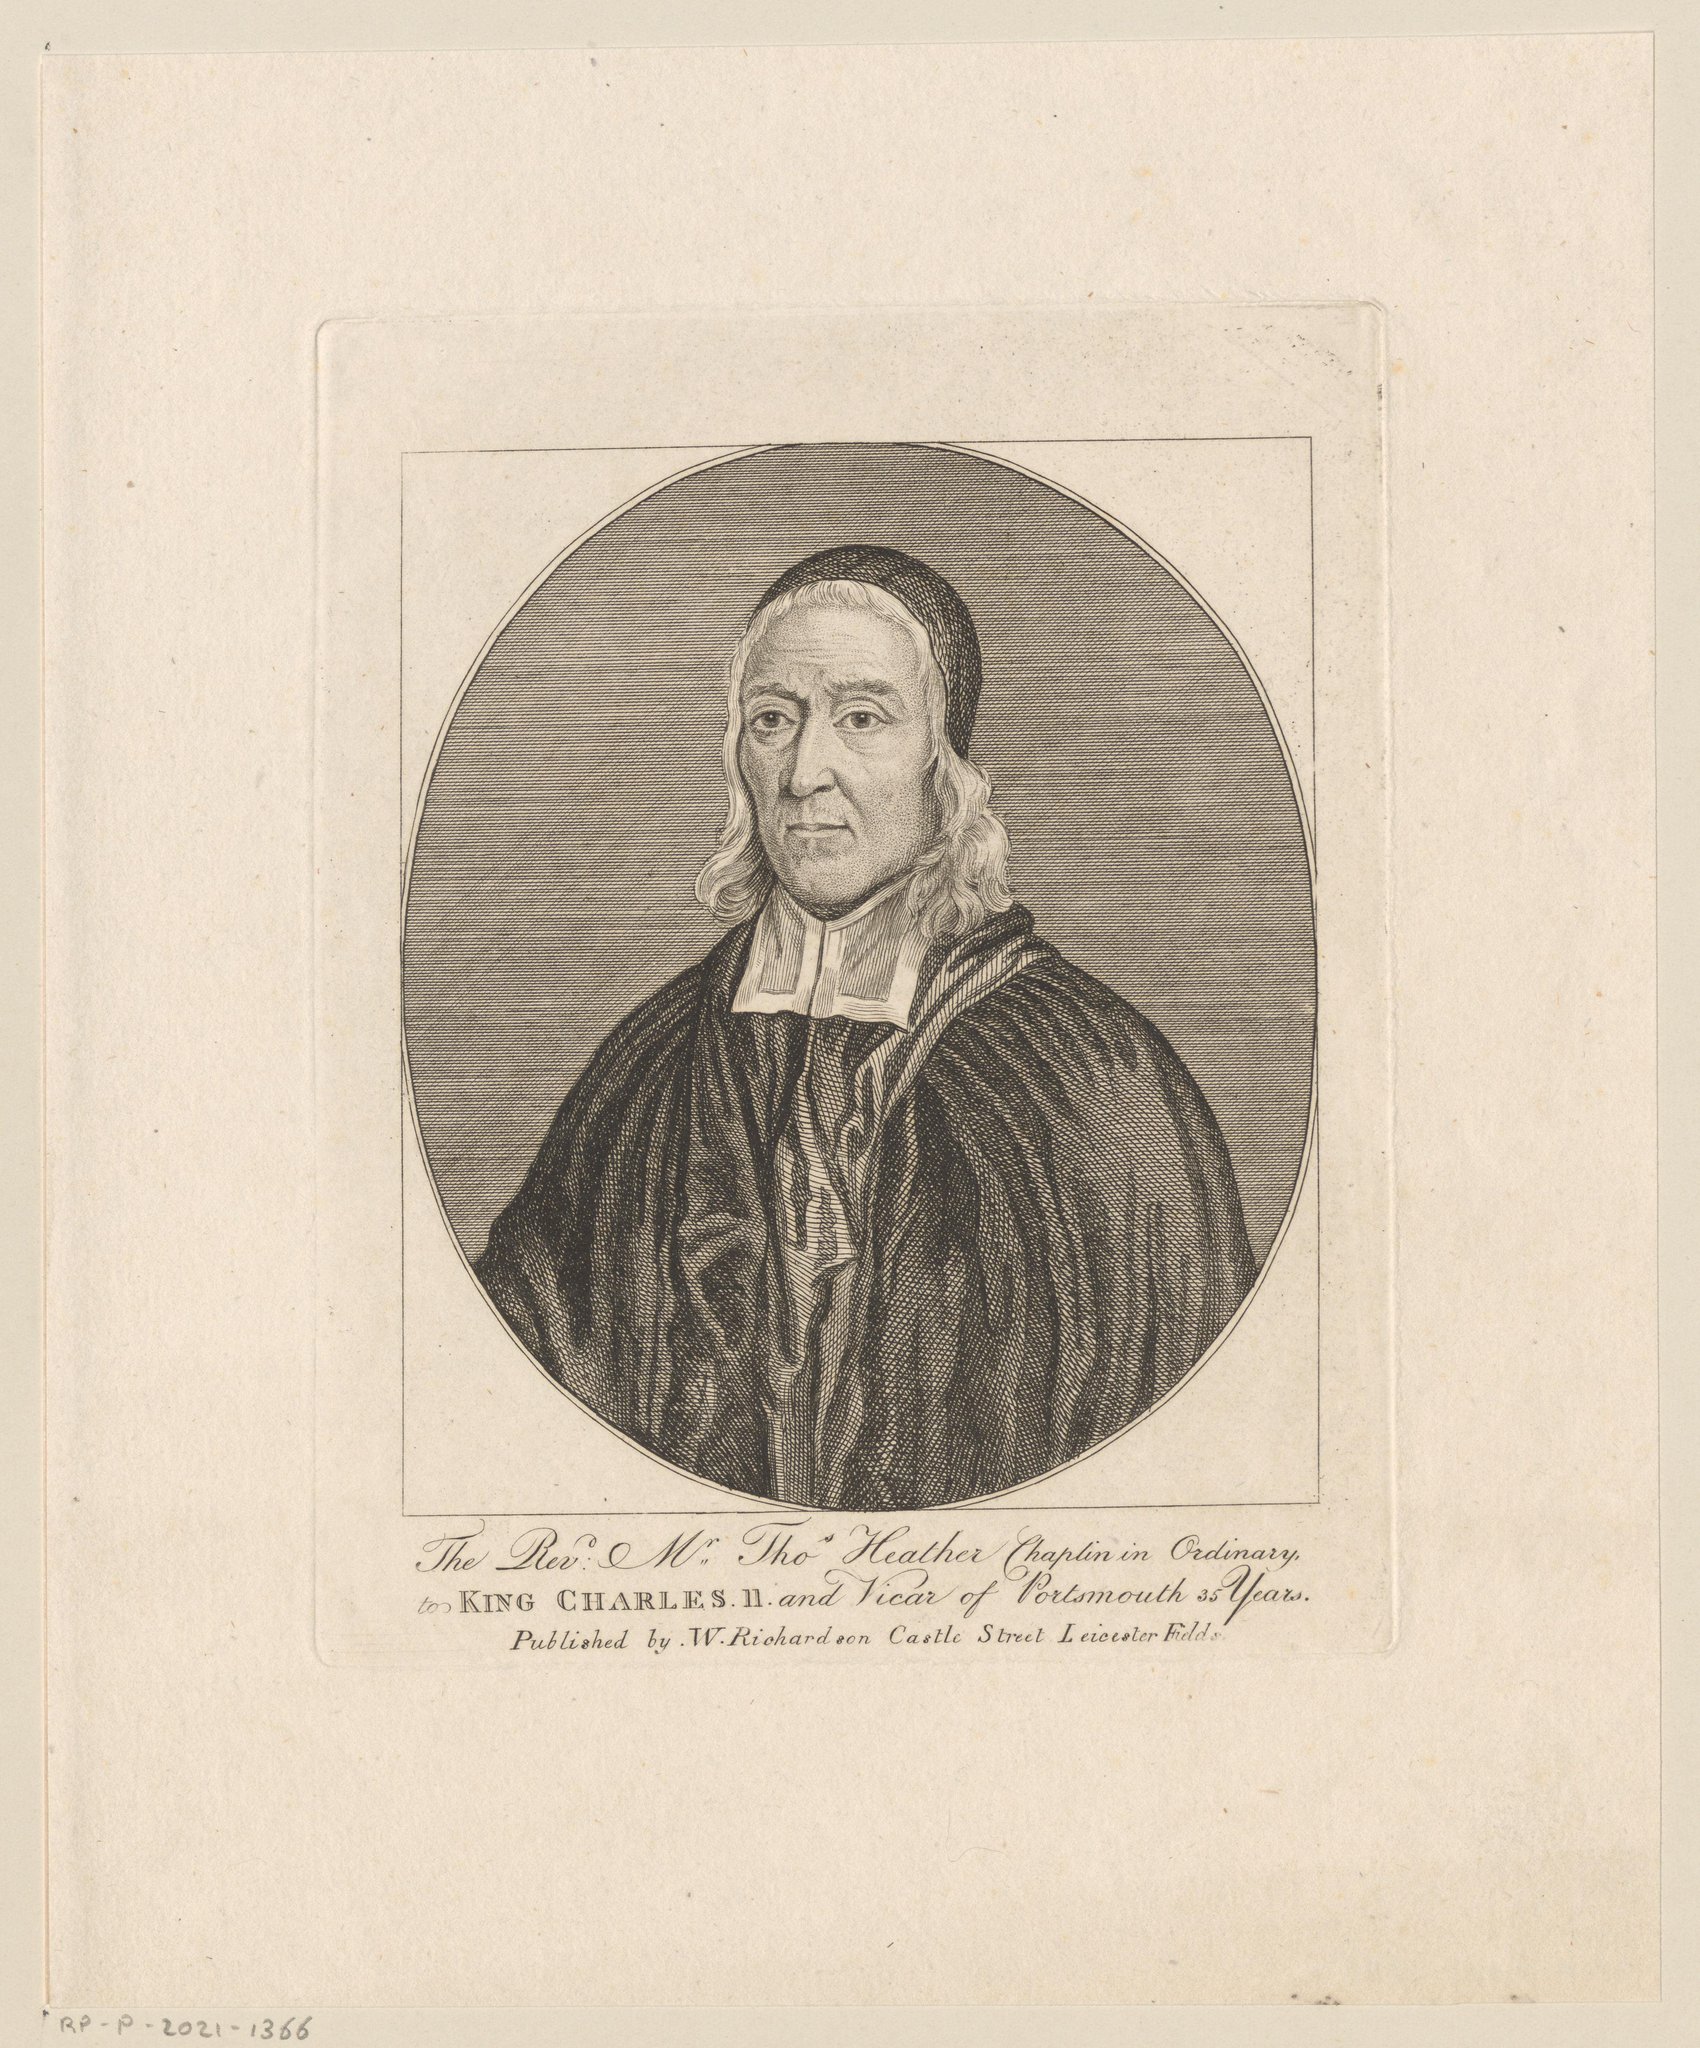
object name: print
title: Portret van Thomas Heather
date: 1778-1812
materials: paper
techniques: engraving, etching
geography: london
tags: historical persons, functionaries and dignitaries ~ episcopal protestant churches